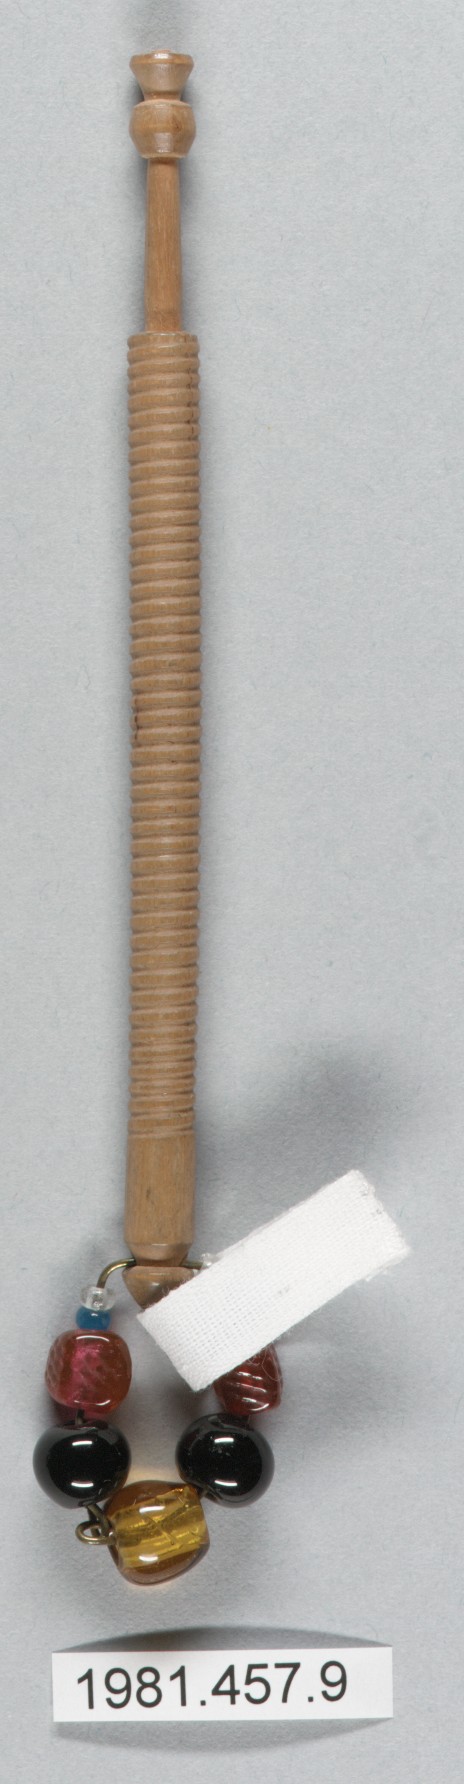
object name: bobbin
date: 1840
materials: wood